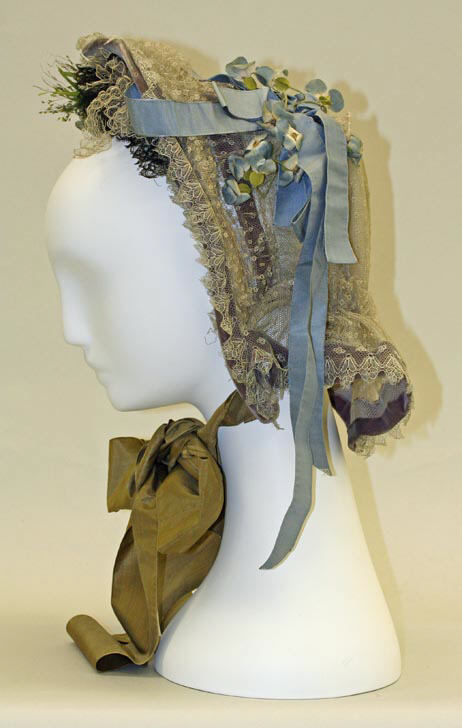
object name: bonnet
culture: american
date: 1863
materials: cotton, metal, silk